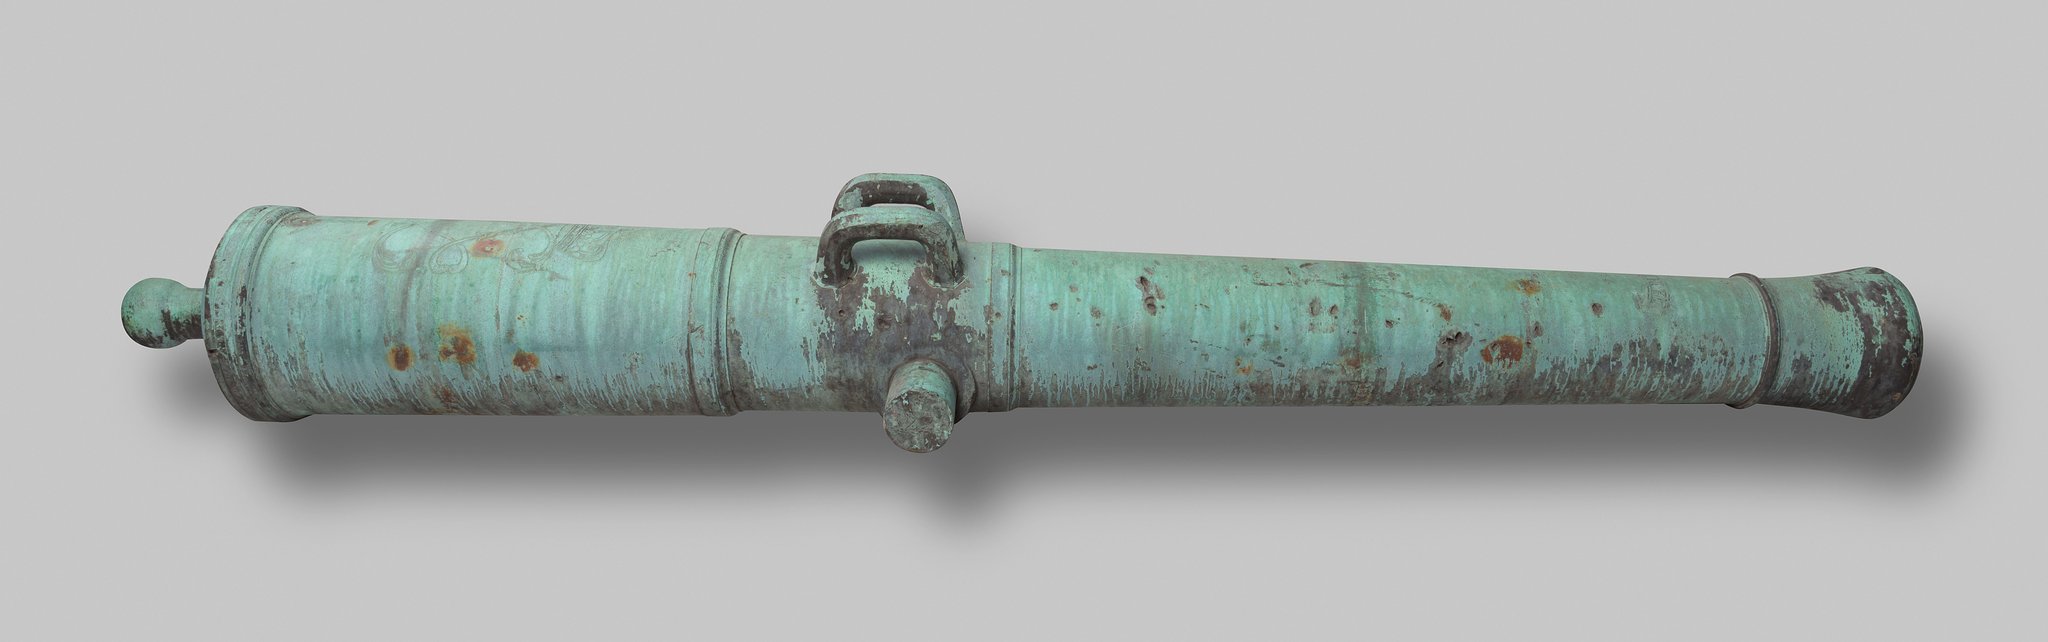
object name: cannon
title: Bronzen kanon La Flêche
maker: i. felix dartieu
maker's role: geschutgieter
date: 1786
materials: bronze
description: Bronzen kanon van 12 cm, glad frans model genaamd La Flêche. Ecuyer Com. de General des fontes de l'artillerie à Strasbourg.